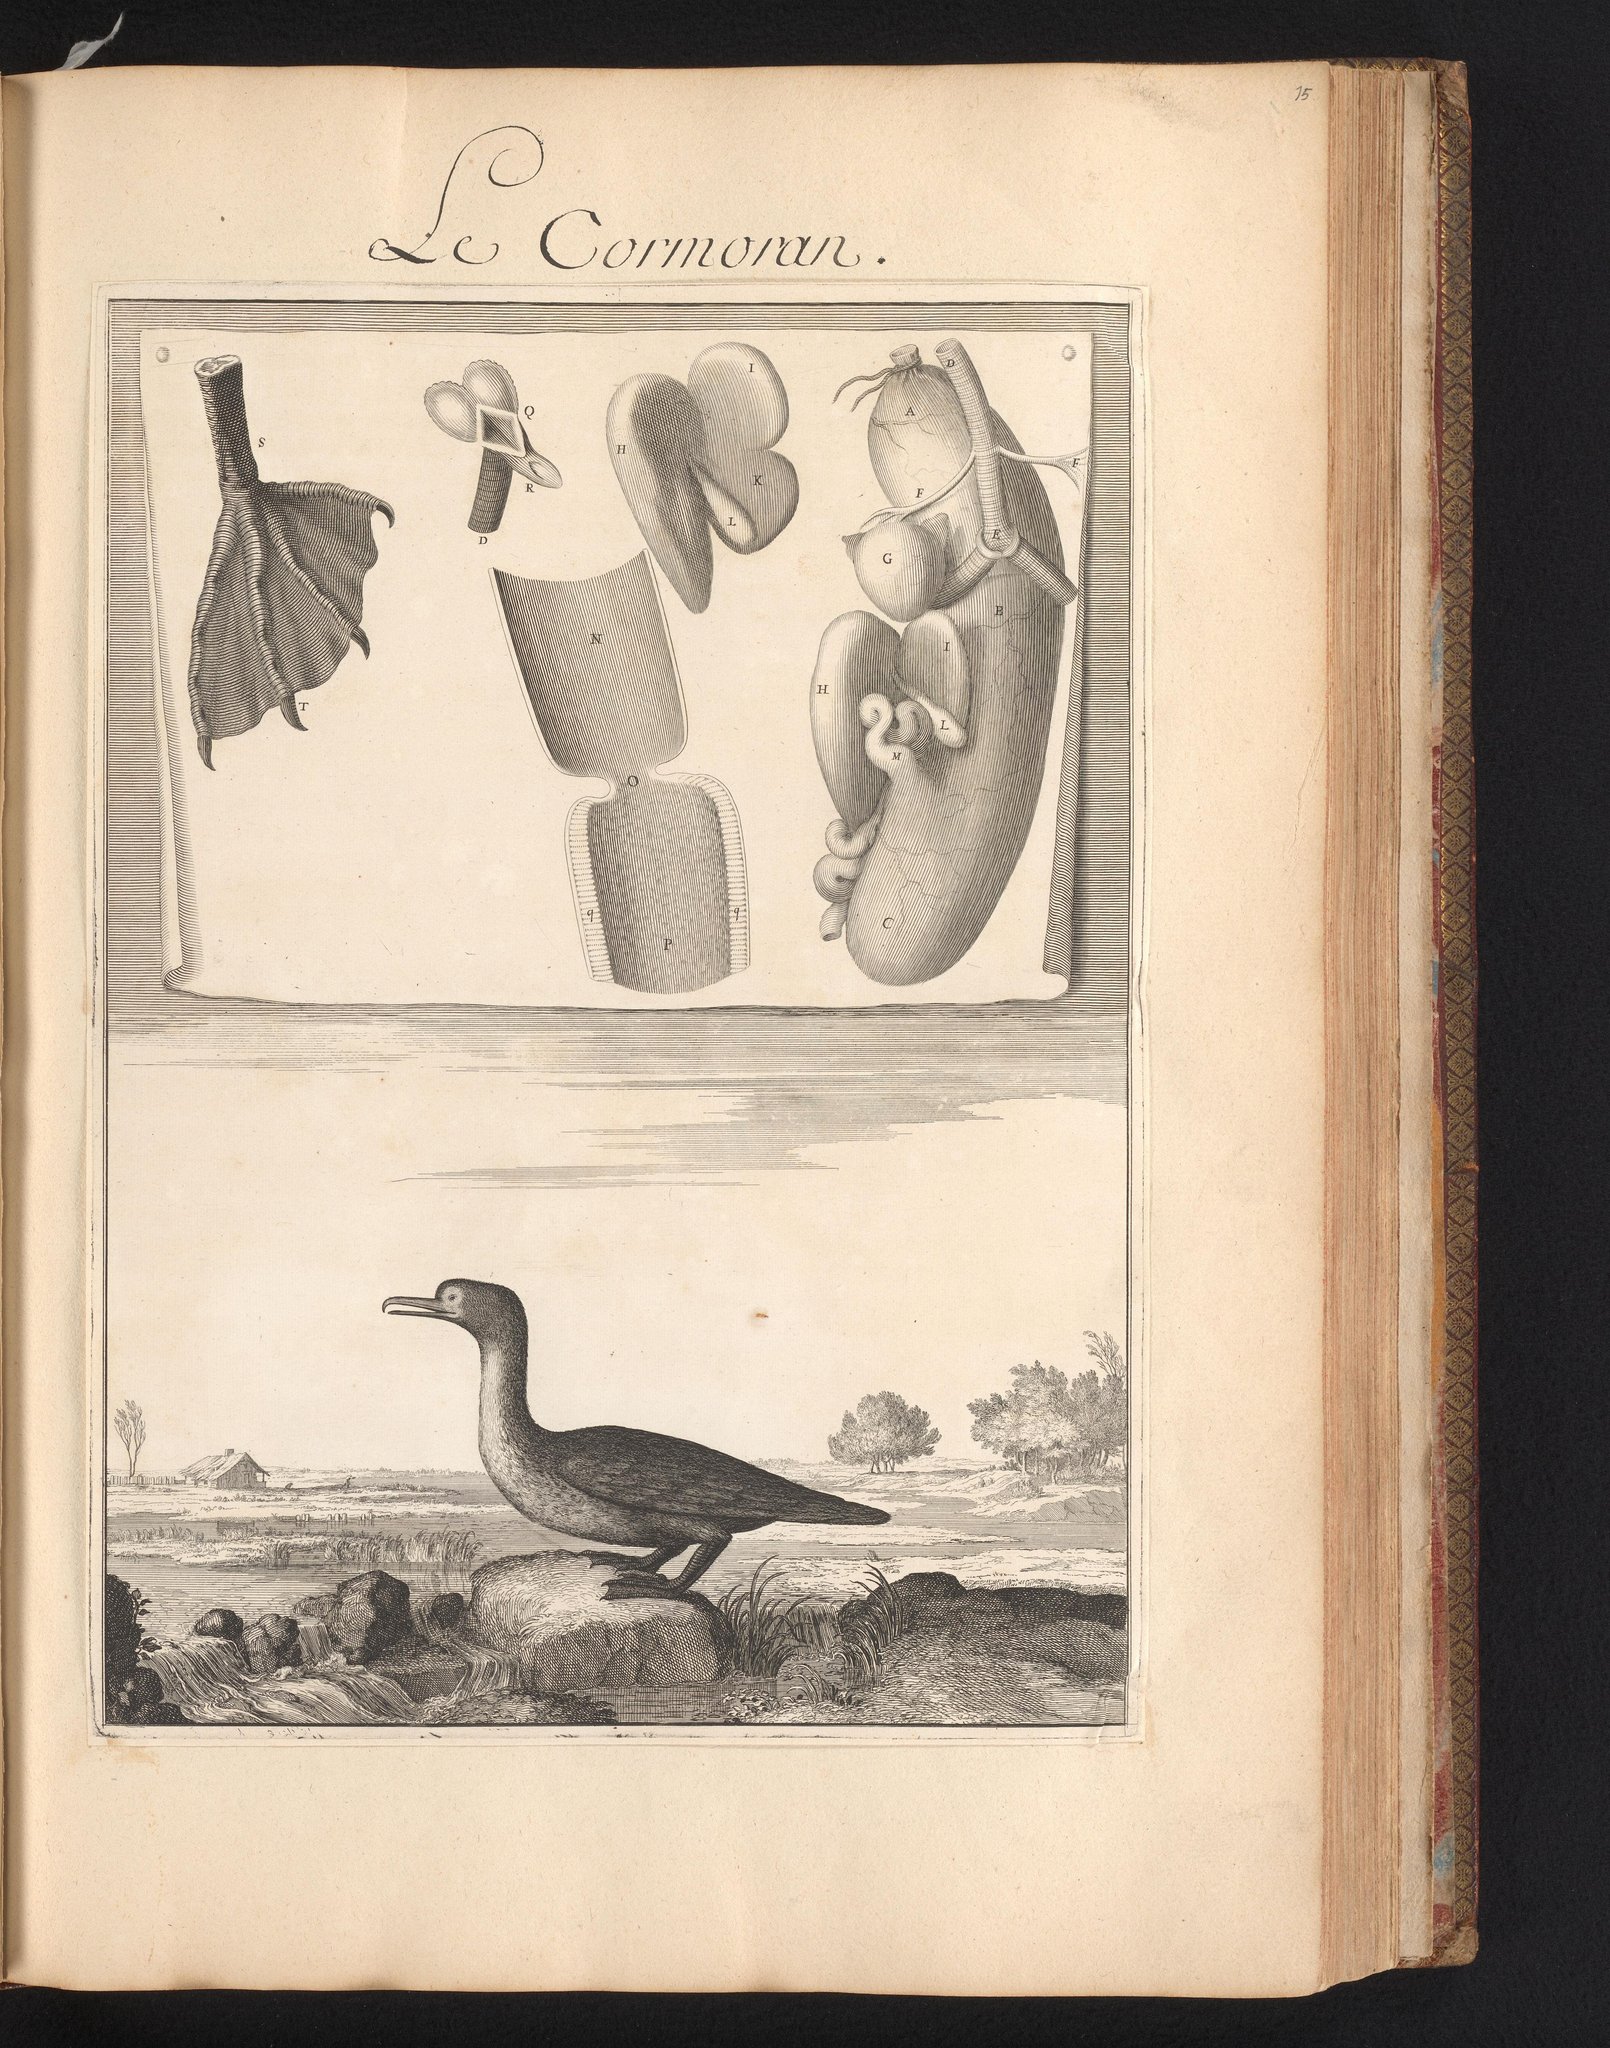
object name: album leaf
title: Aalscholver (Phalacrocoracidae) met bovenaan op een blad de organen en botten van het dier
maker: sébastien leclerc (i)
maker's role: print maker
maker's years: 1637-1714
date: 1676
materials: ink, paper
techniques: engraving, etching, pen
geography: paris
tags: dissection, water-birds (+ anatomy of animals), water-birds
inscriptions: inscription: ‘Le Cormoran.’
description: Prent uit: Perrault, Claude. Mémoires pour servir à l'histoire naturelle des animaux. Dressez par M. Perrault de l'Académie Royale des Sciences (...). Parijs: Imprimerie Royale, 1676.